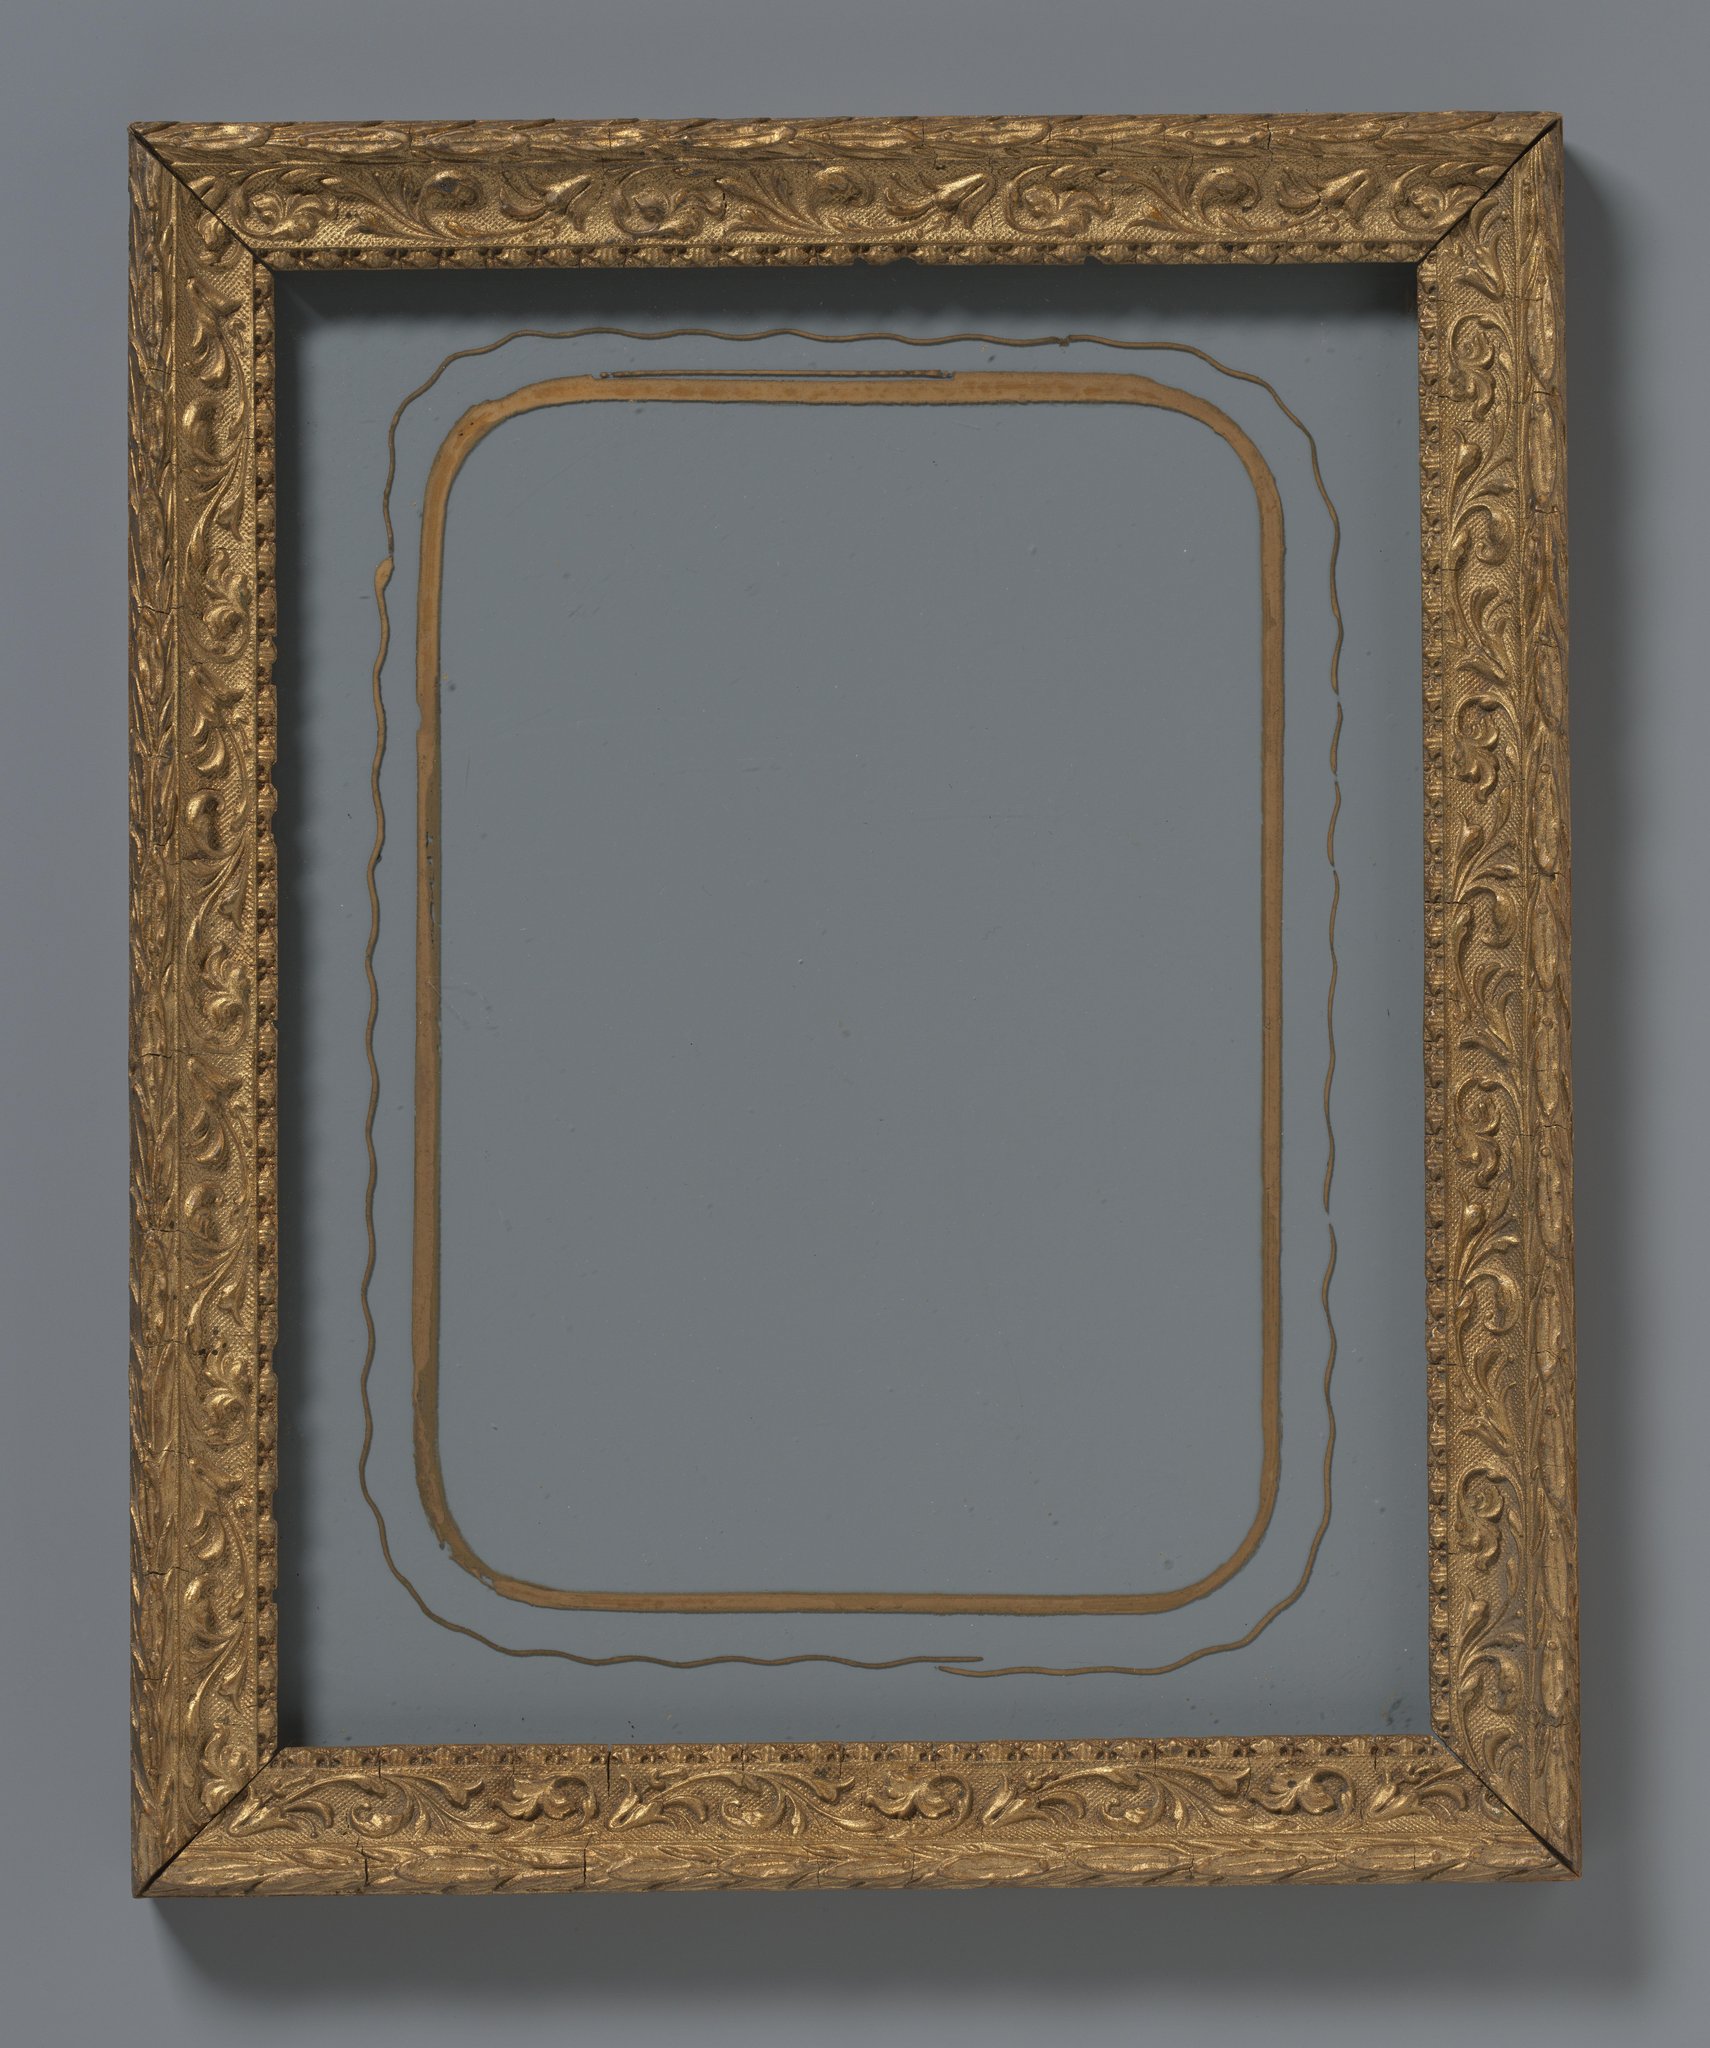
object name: frame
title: Fotolijst met houtsnijwerk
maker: Anonymous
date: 1850-1910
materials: glass, metal, wood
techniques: cutting